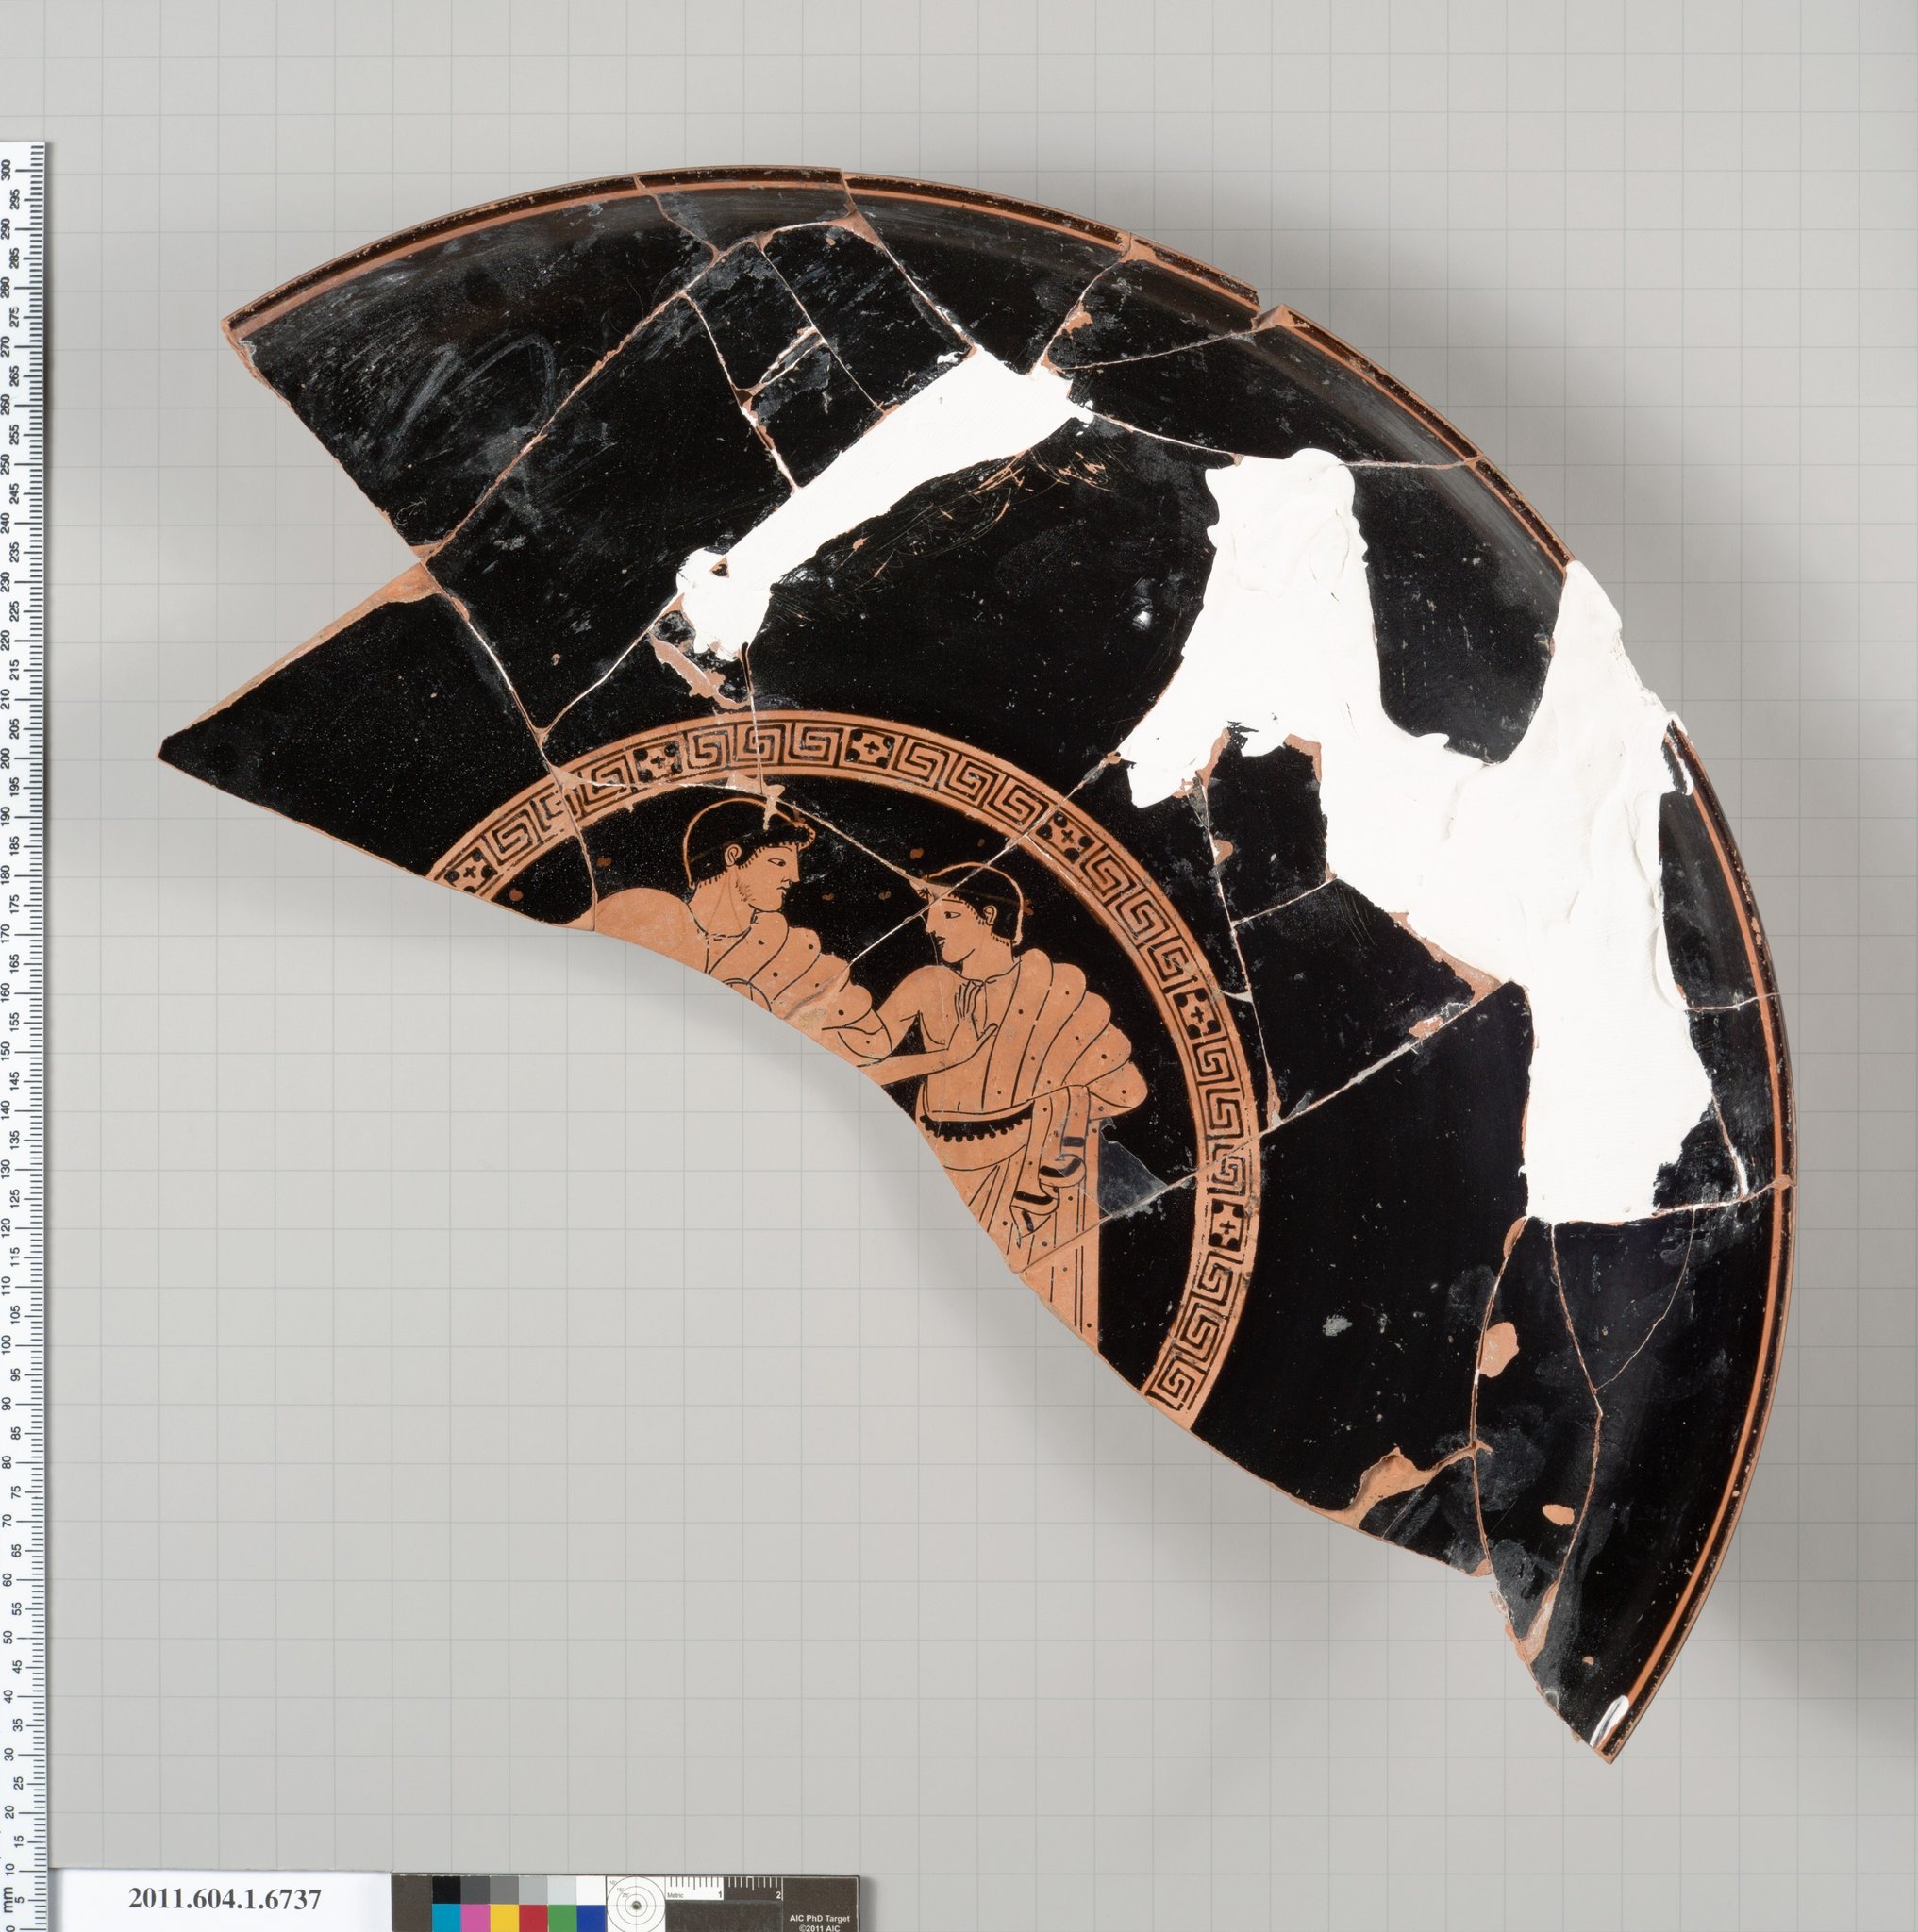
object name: kylix fragment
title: Terracotta fragment of a kylix (drinking cup)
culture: greek, attic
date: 490-470 BCE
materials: terracotta